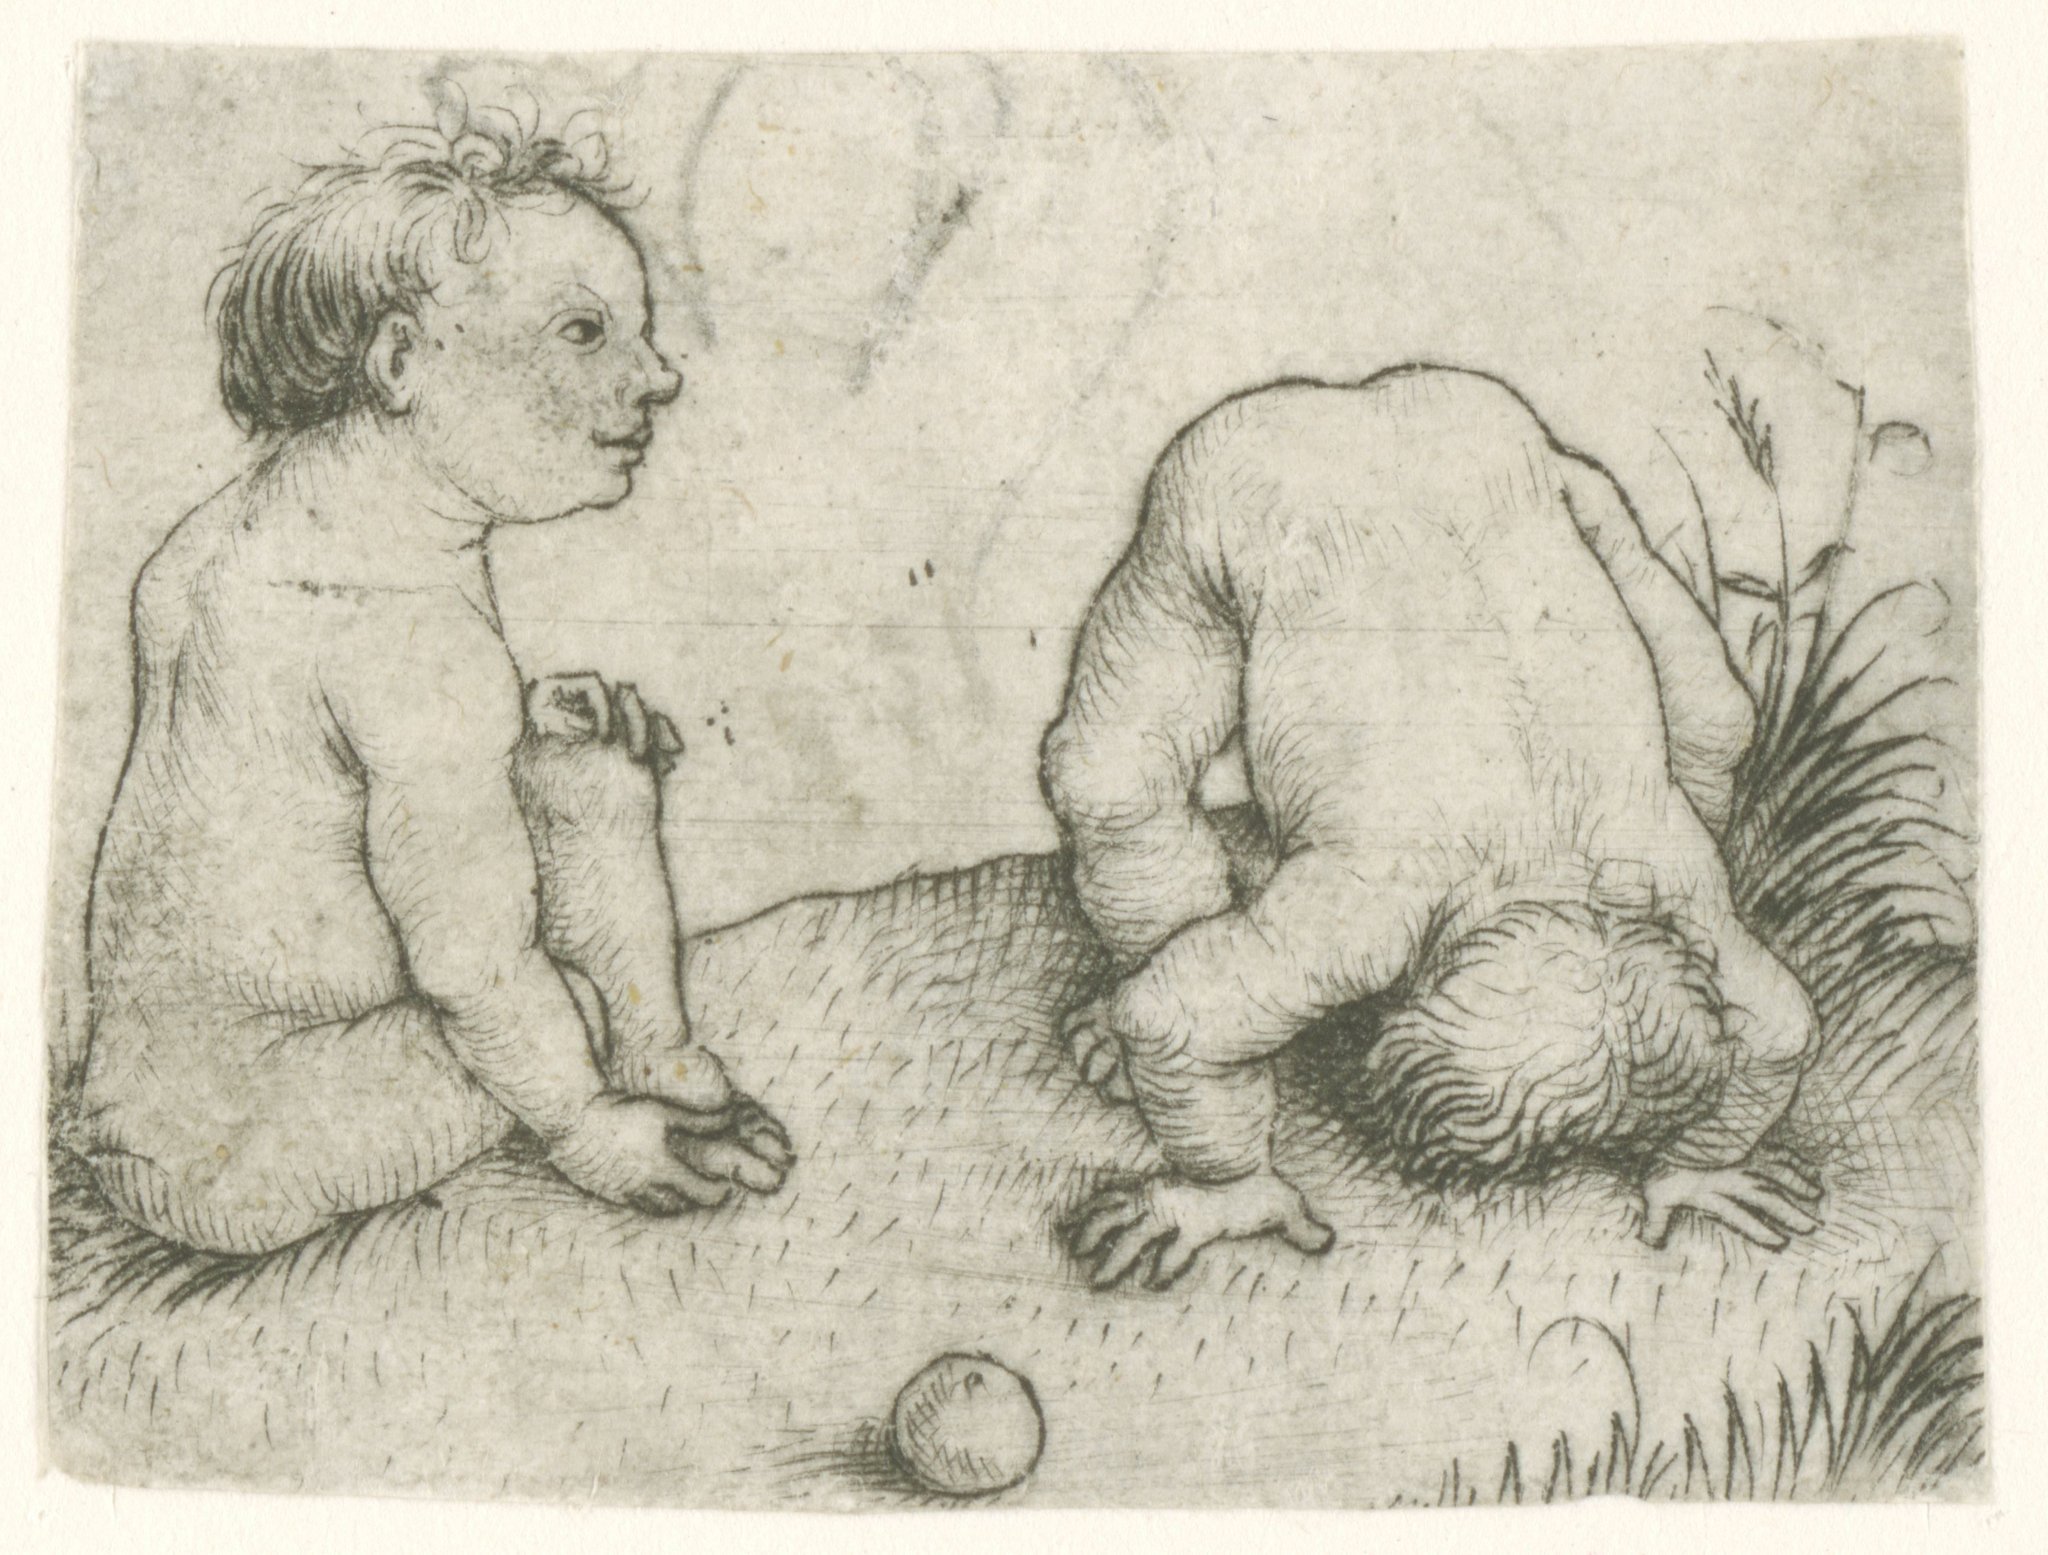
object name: print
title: Twee spelende kinderen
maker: meester van het amsterdamse kabinet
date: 1470-1475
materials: paper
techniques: drypoint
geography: germany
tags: toddler (male), playing toddler; child amusing itself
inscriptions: collector's mark: Lugt 2228a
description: Eén peuter zit, de ander probeert op zijn hoofd te gaan staan.